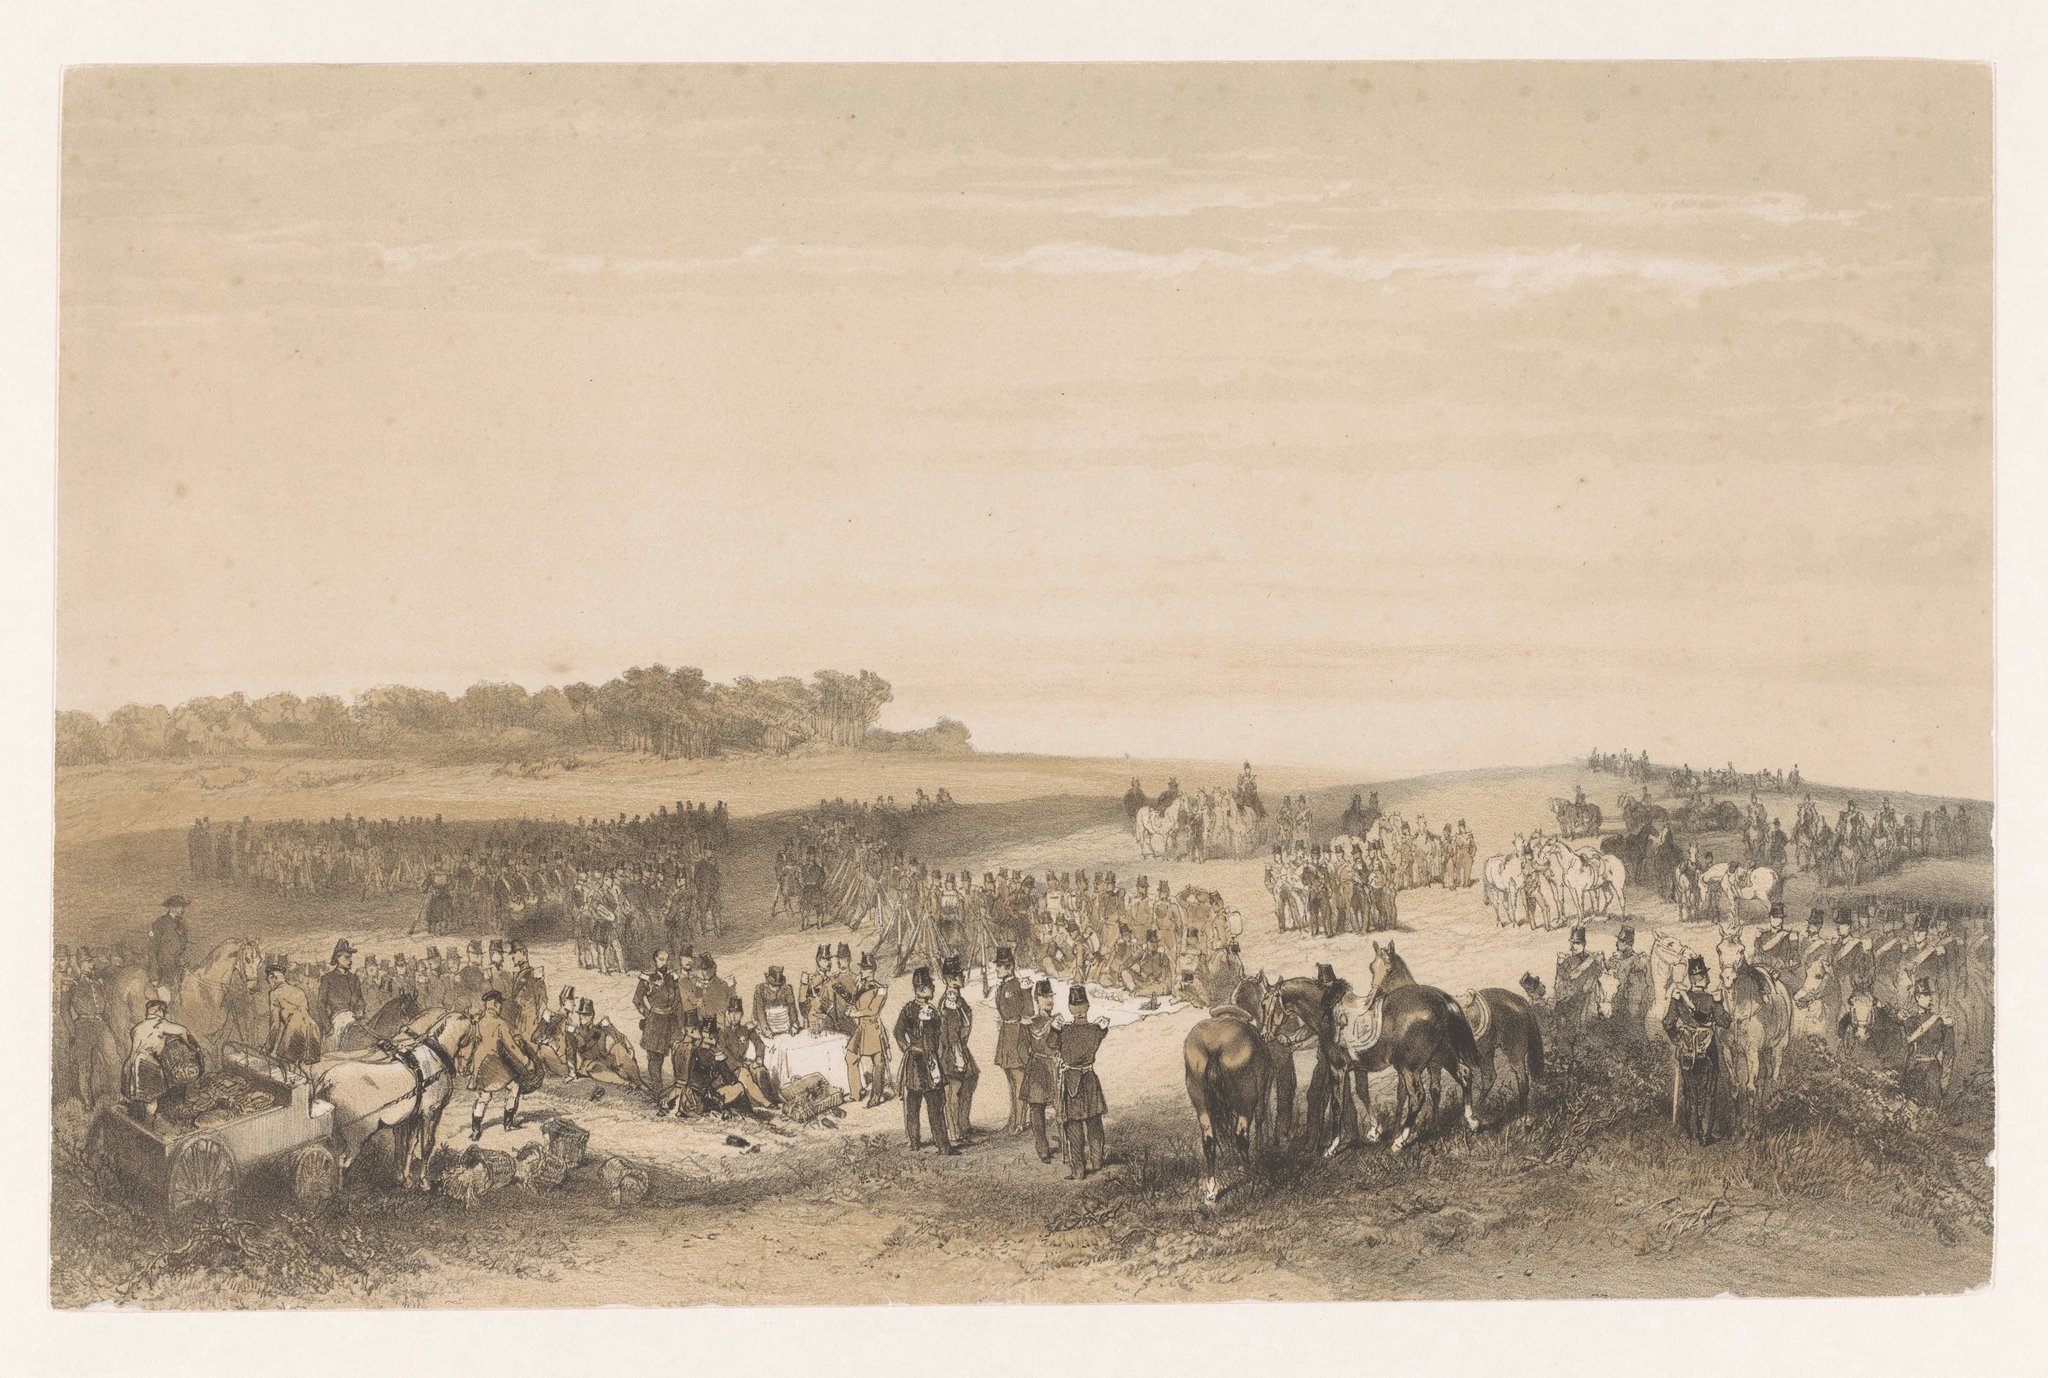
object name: print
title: Militairen op de heide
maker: charles rochussen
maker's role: draughtsman, painter, print maker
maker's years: 1814-1894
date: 1824-1894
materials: paper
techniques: tone lithography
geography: netherlands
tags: the soldier; the soldier's life, landscapes (+ landscape with figures, staffage)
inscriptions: collector's mark: Lugt 2760, collector's mark: Lugt 2228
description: Nederlandse militairen met paarden en een wagen op de heide.